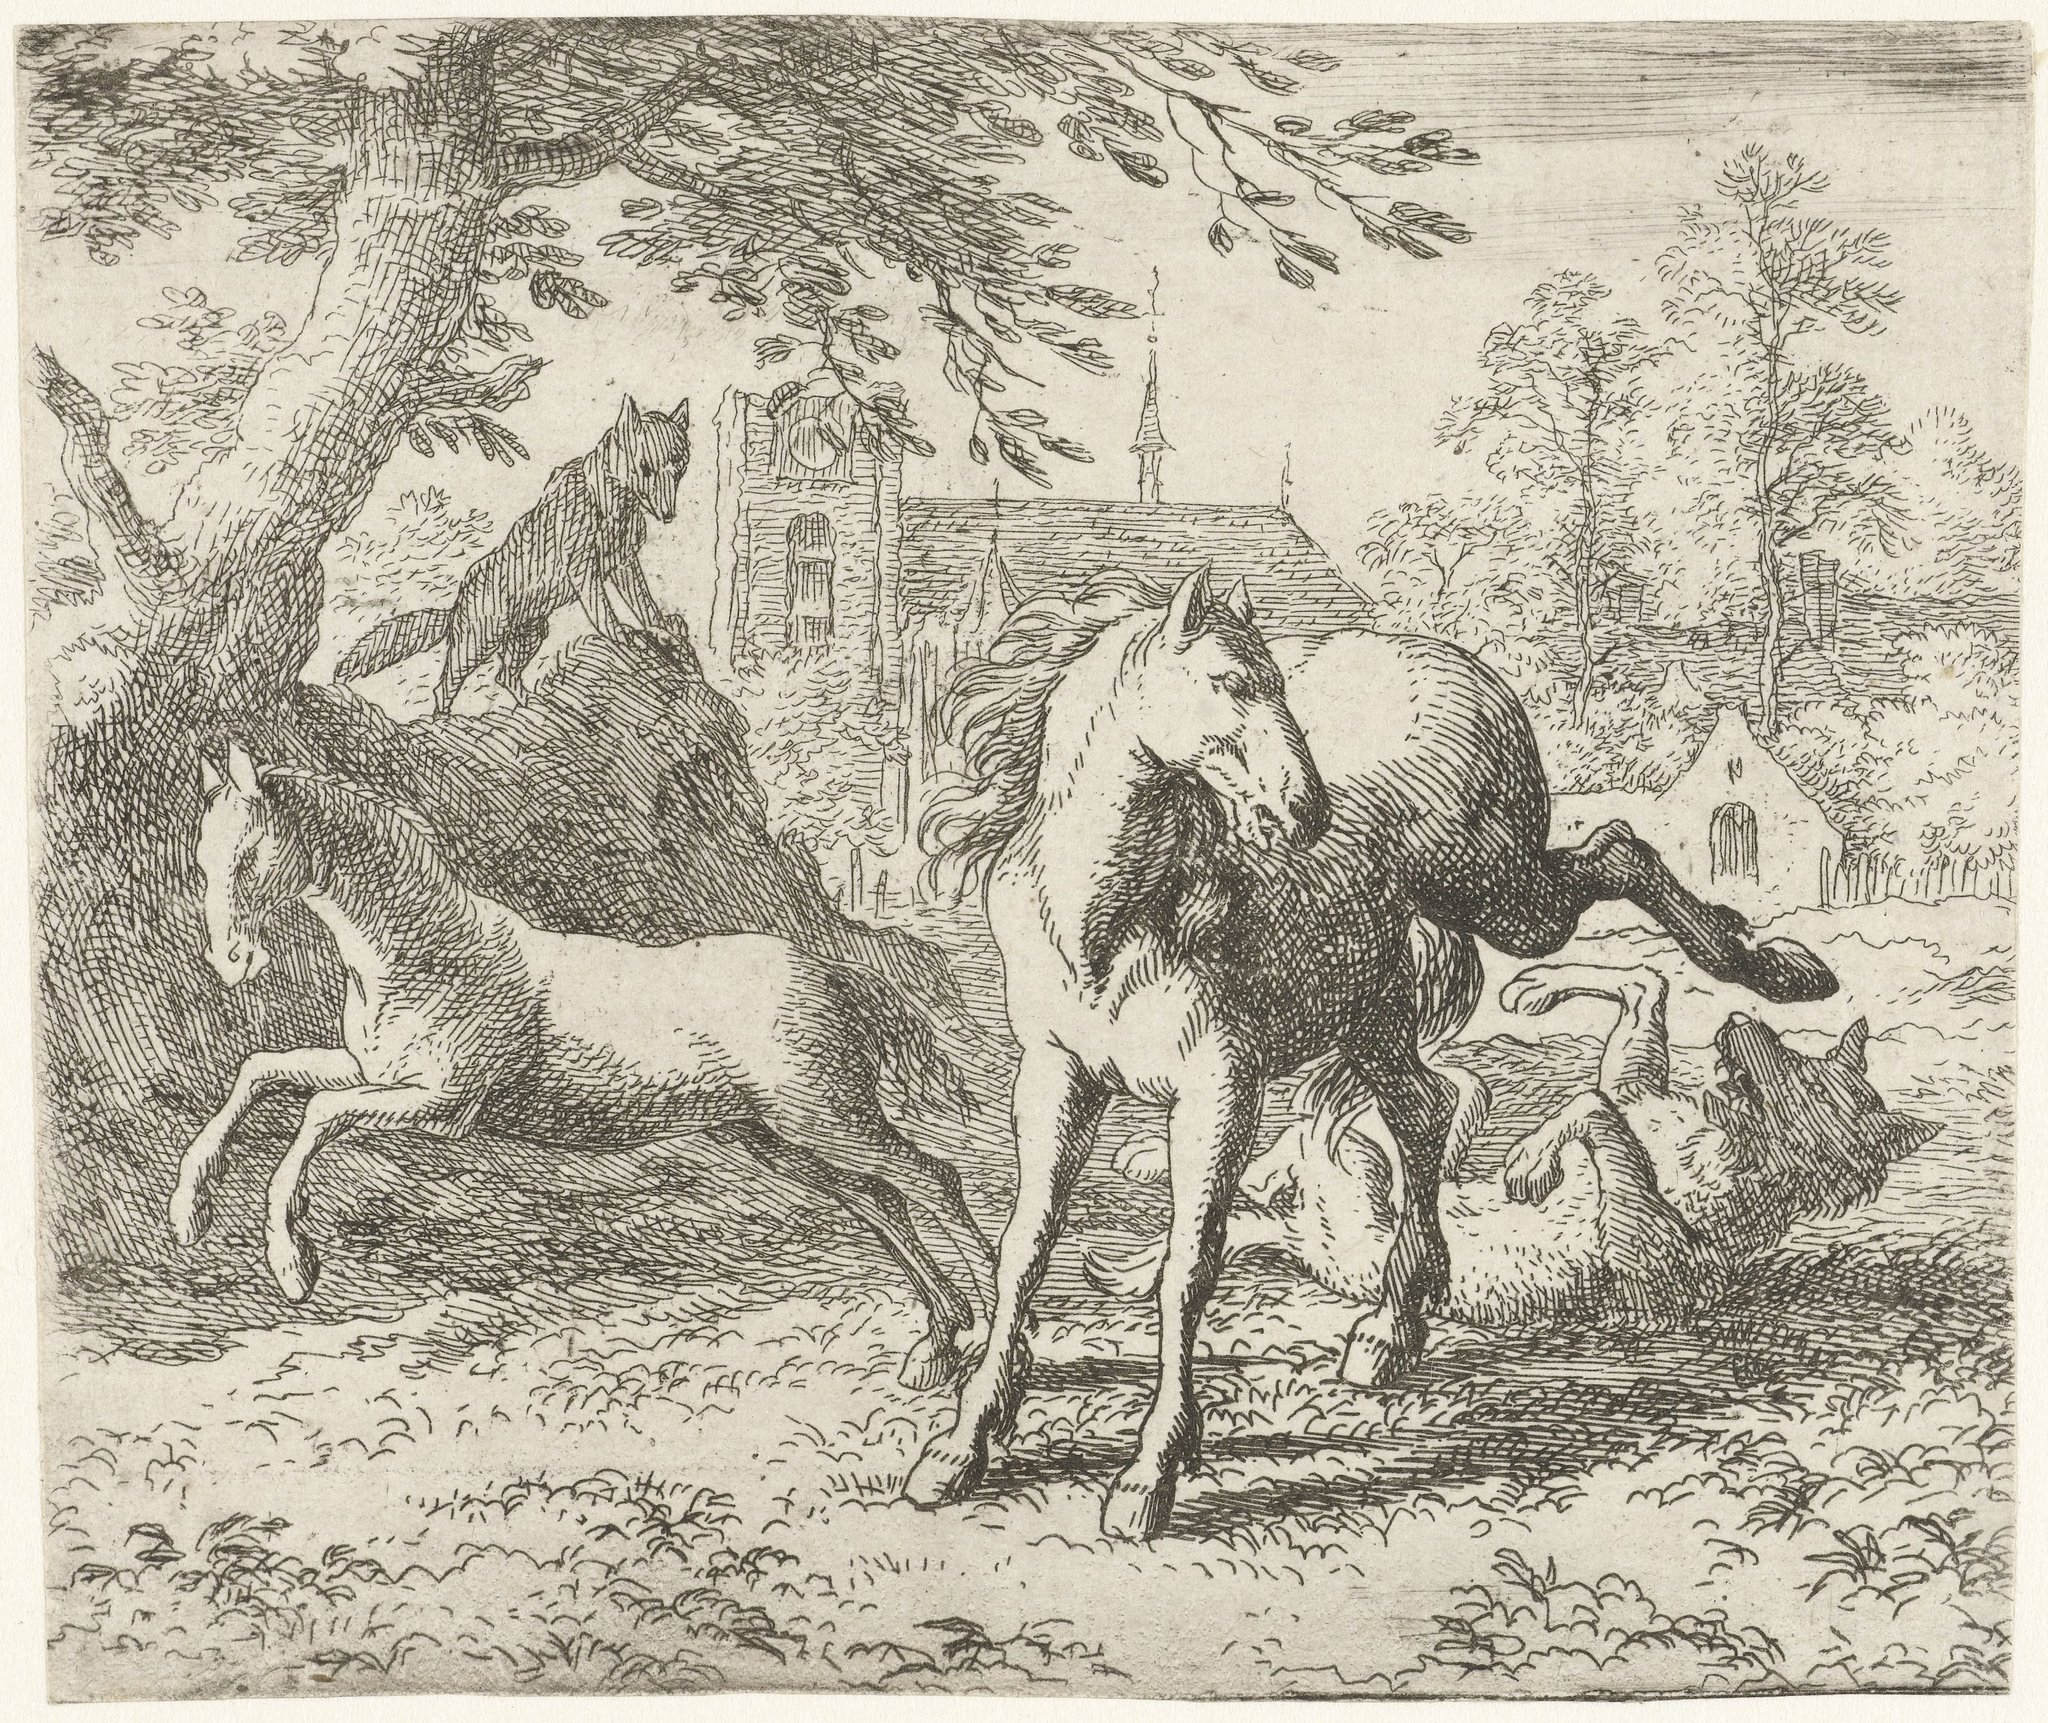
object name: print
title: Reinaert de vos strikt Isengrijn de wolf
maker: allaert van everdingen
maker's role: draughtsman, painter, print maker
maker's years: 1621-1675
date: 1665-1675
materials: paper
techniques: etching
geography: netherlands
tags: fable of reynard the fox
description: Isengrijn de wolf wordt omvergelopen door twee paarden. Reinaert de vos kijkt vanaf een heuvel toe.